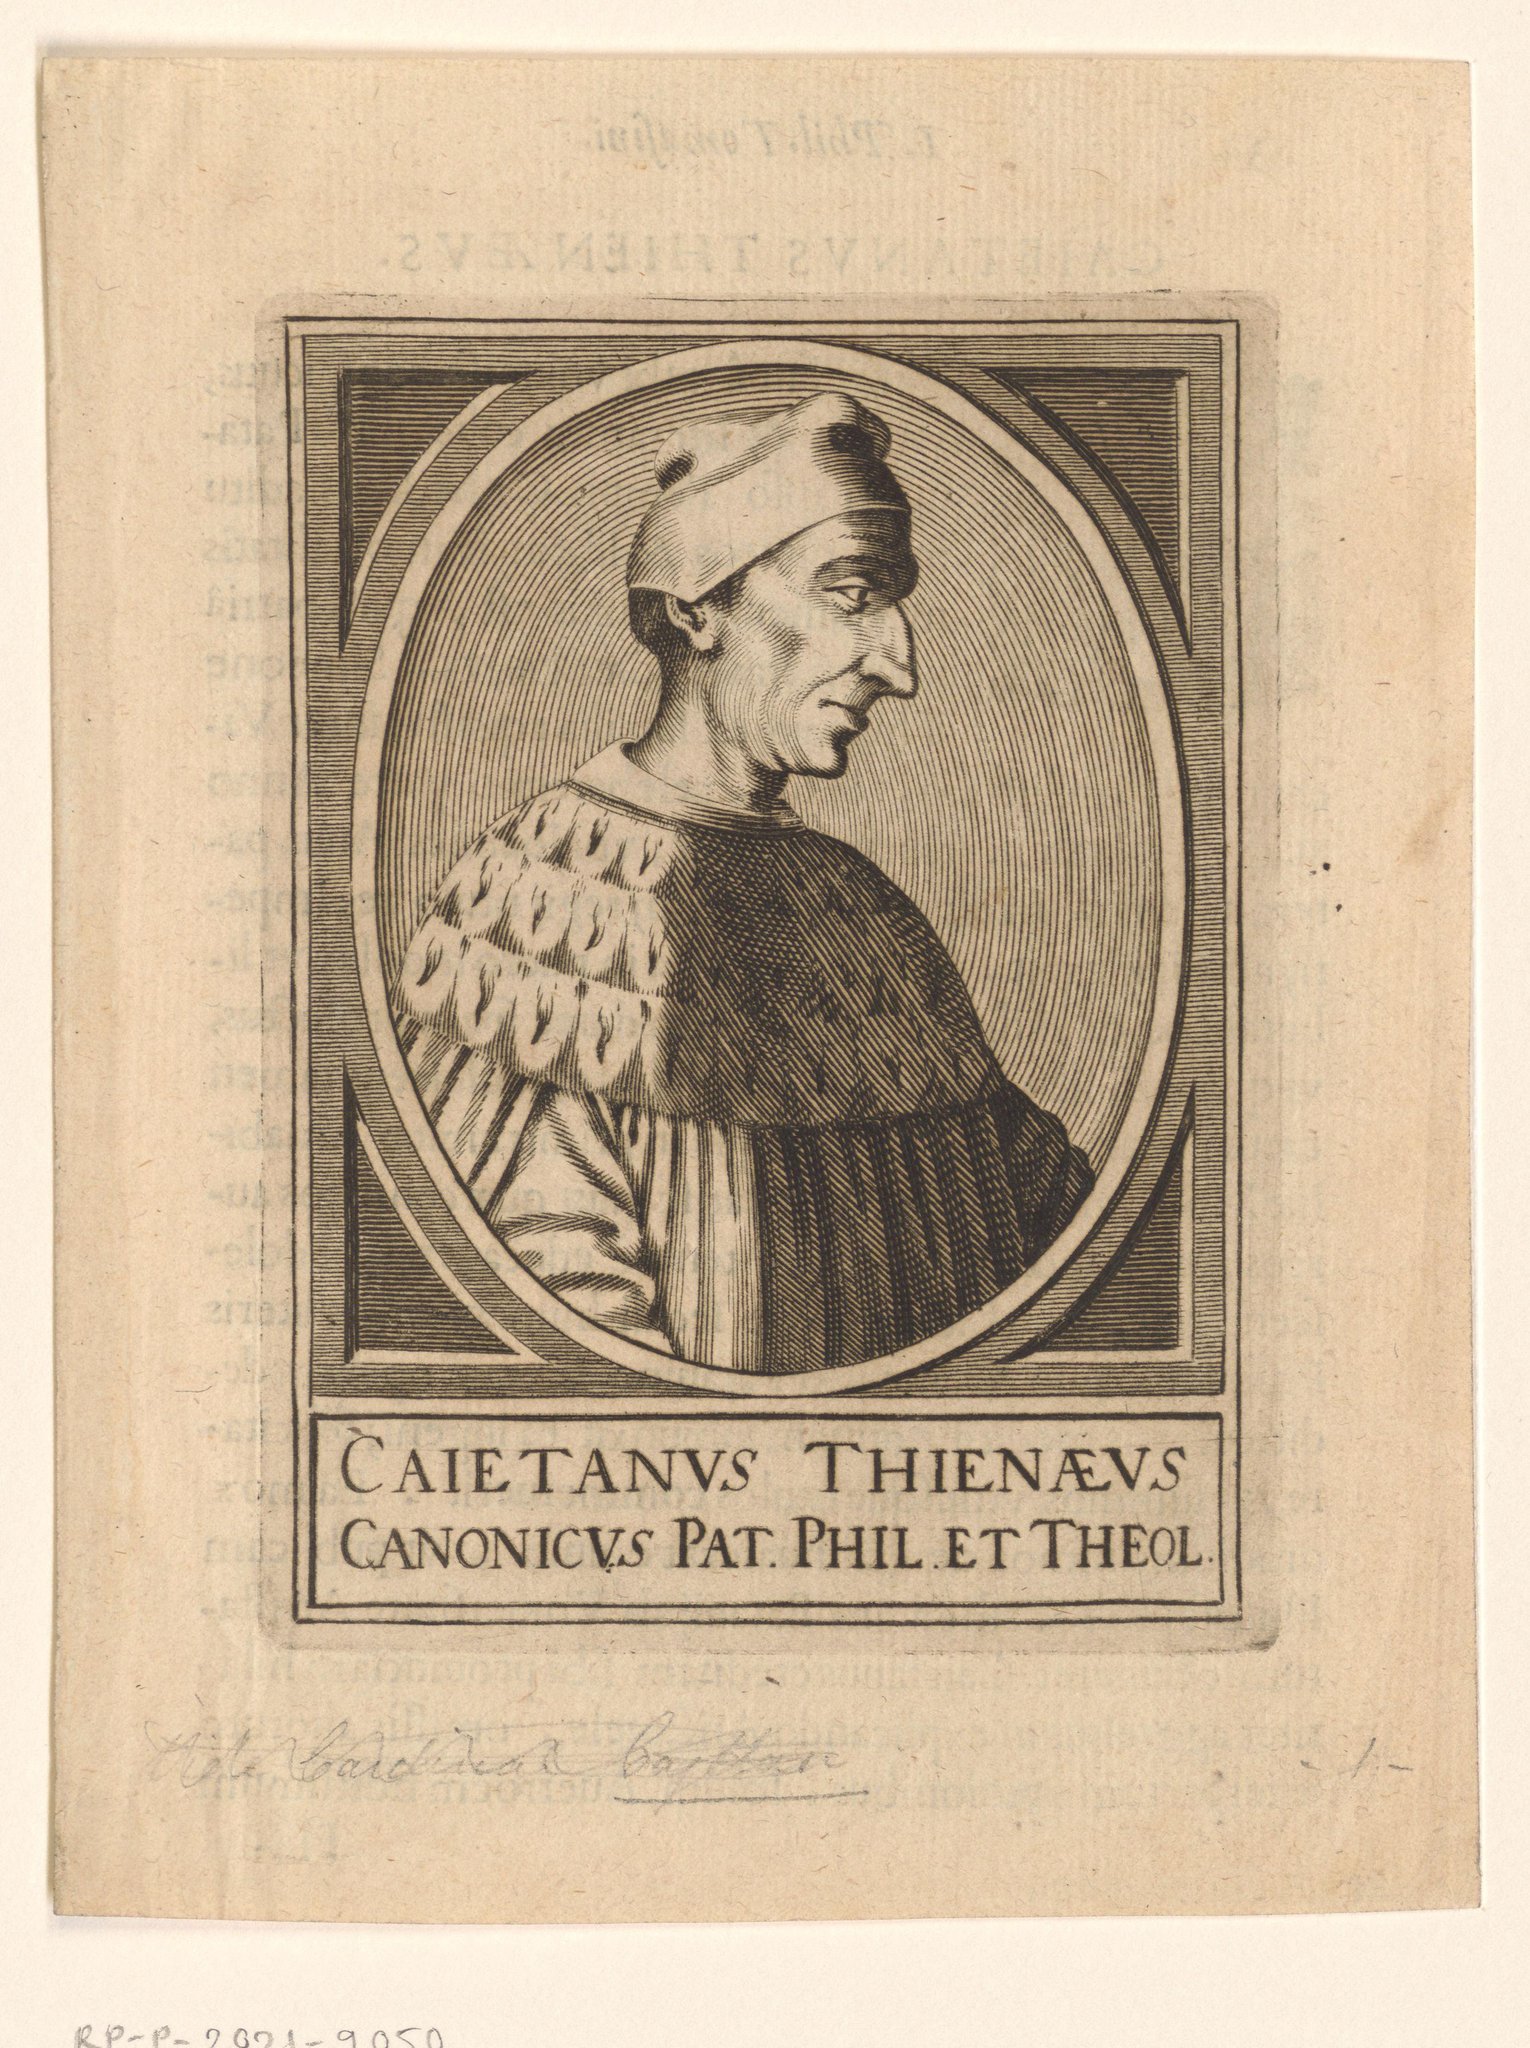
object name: book illustration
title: Portret van Cajetanus van Thiene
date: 1644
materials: paper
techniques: engraving, letterpress printing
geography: padua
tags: naples, ethics; 'etica' (ripa), historical persons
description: Prent uit: Tomasini, Giacomo Filippo. Elogia virorum literis et sapientia illustrium ad vivum expressis imaginibus exornata. Padua: Sebastiano Sardi, 1644, p. 33.